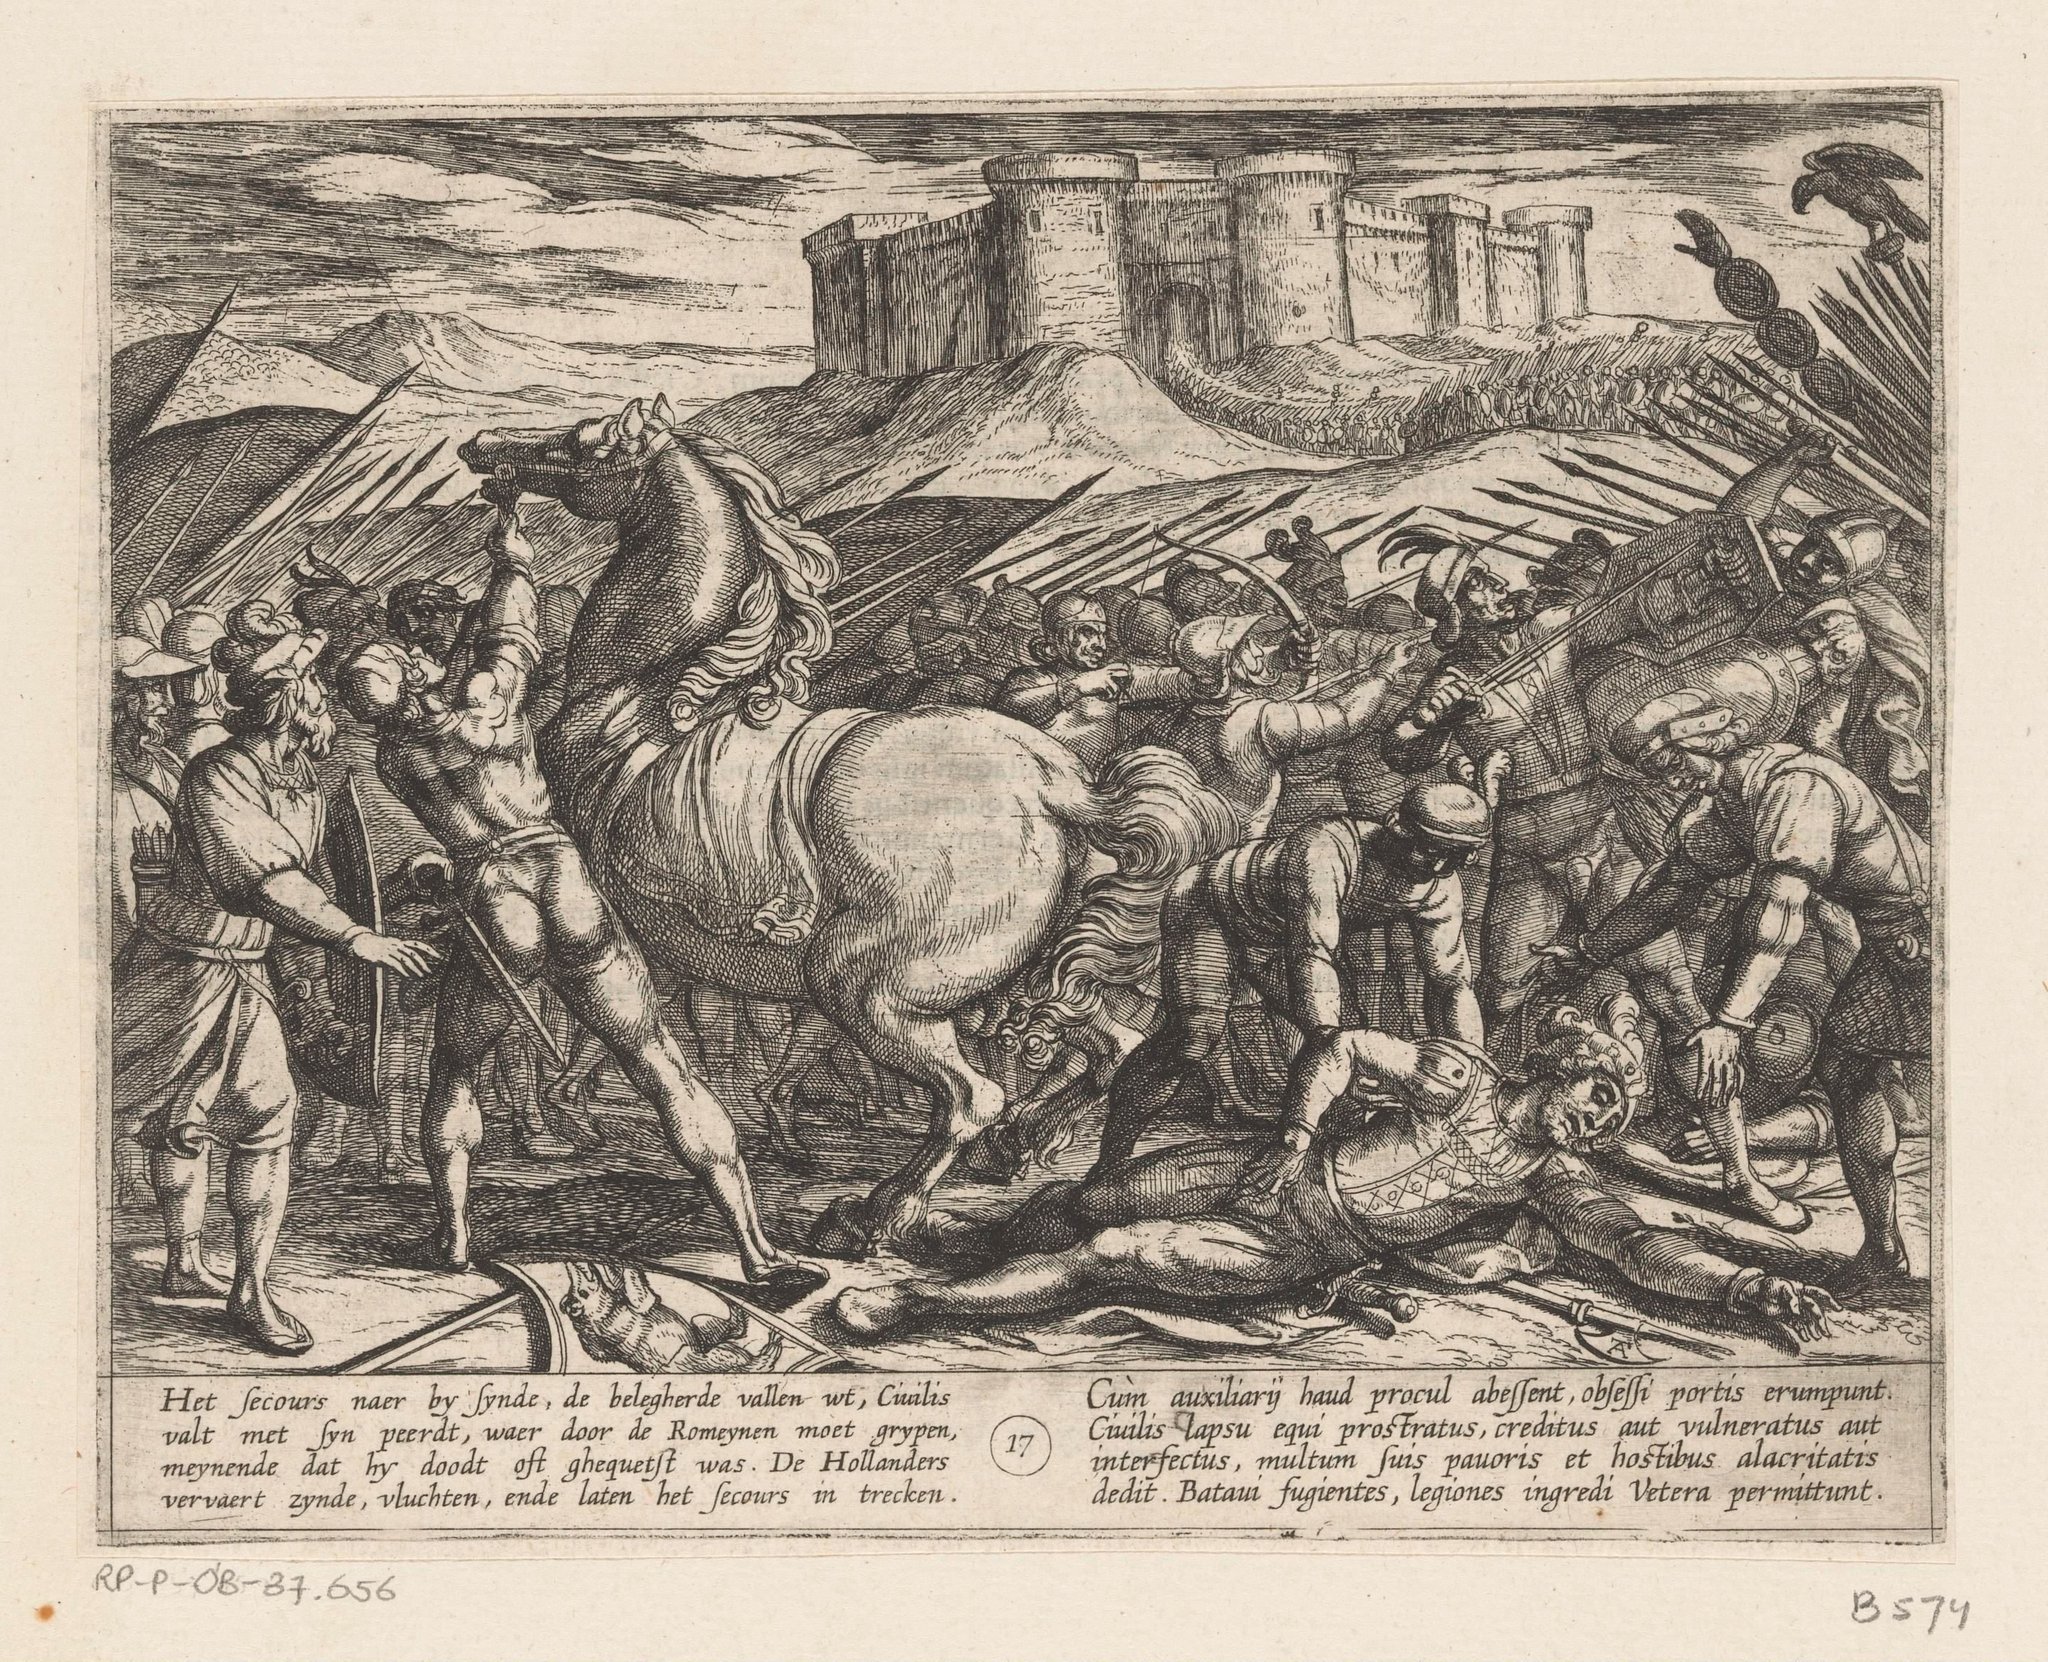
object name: print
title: De Romeinen door Julius Civilis' paard misleid dat hij dood of gewond is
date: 1611-1612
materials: paper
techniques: etching, letterpress printing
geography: southern netherlands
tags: battle, the soldier; the soldier's life, (story of) julius claudius civilis, extinct, 'historical' peoples (with name)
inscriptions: collector's mark: Lugt 240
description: De Romeinen denken dat Julius Civilis gewond of dood is, omdat ze zijn paard zien. Julius Civilis ligt op de grond. Achter hem strijden de Bataven tegen de Romeinen. Onderschrift in het Nederlands en in het Latijn.